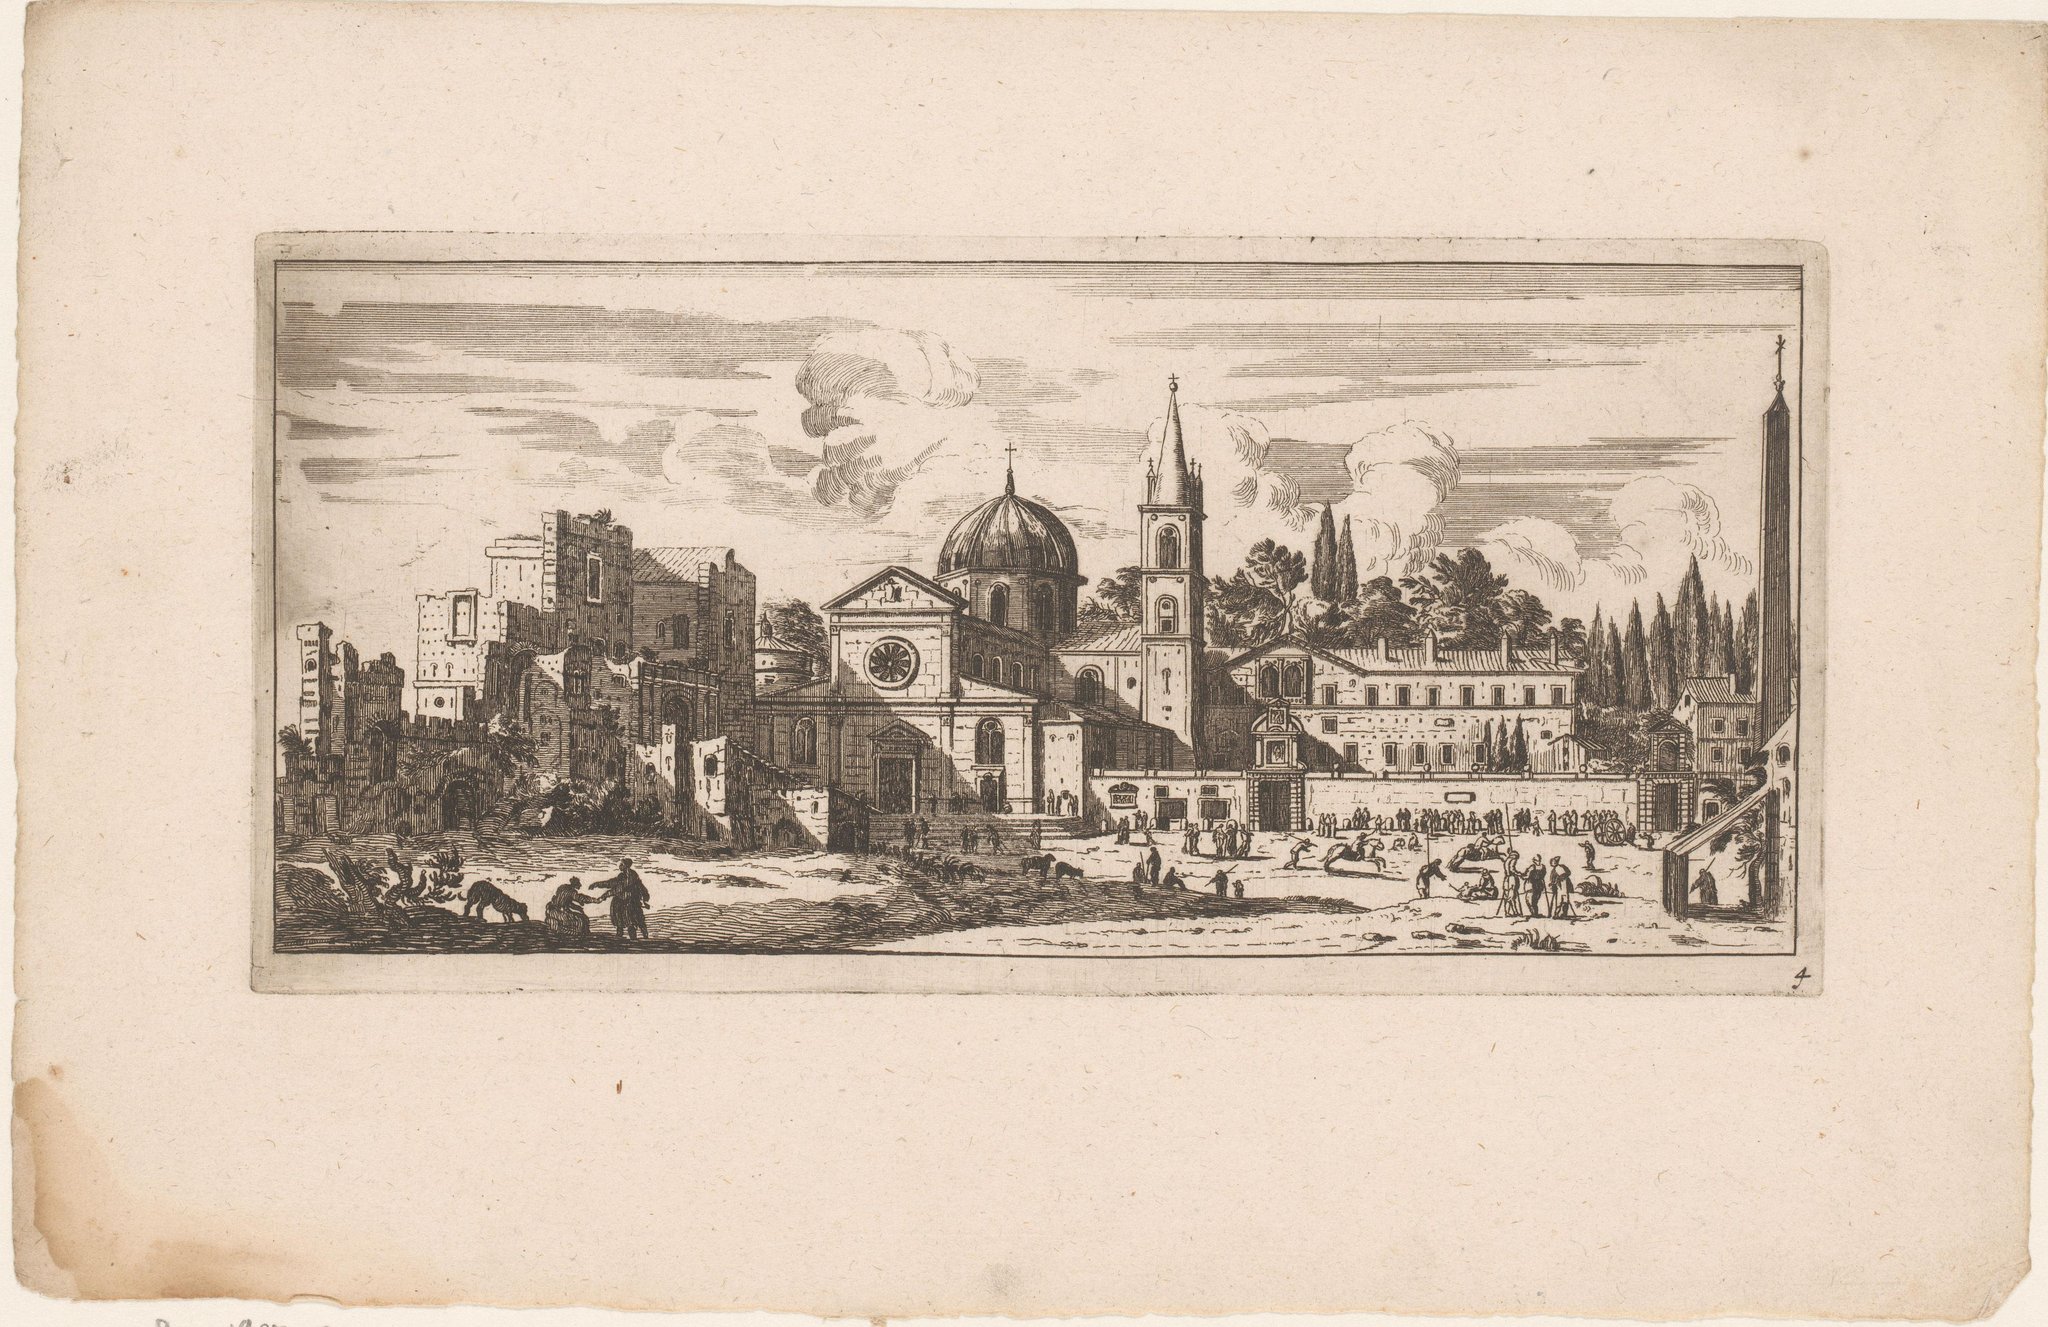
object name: print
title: Gezicht op de Santa Maria del Popolo, te Rome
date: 1648-1712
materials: paper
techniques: etching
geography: amsterdam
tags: church (exterior)